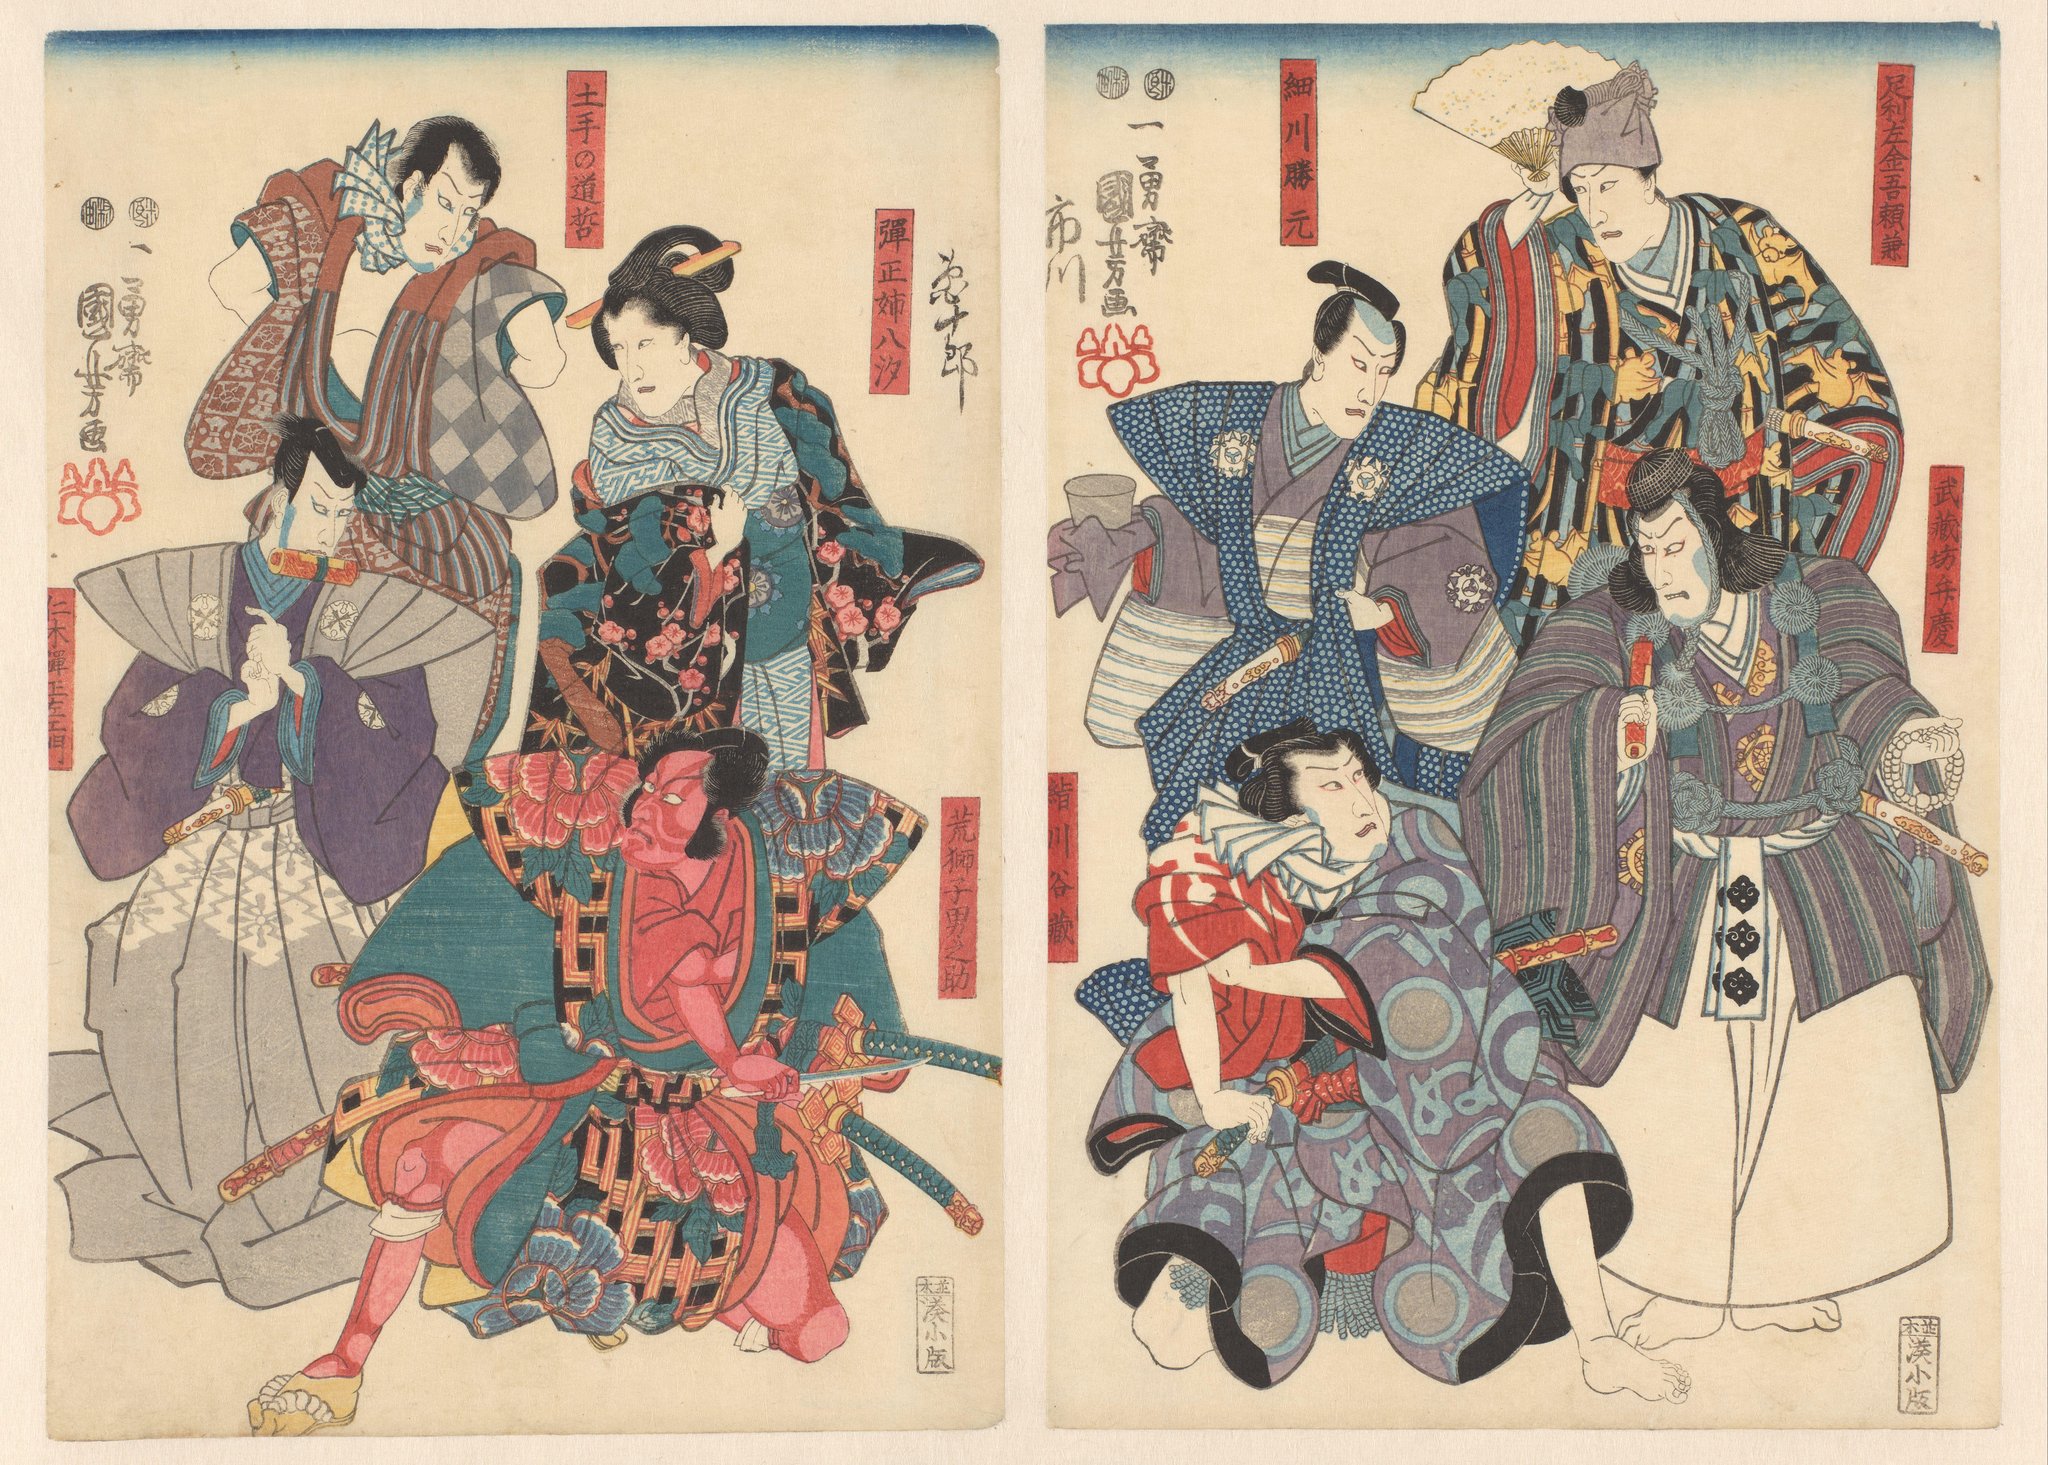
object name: print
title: Ichikawa Danjûrô VIII in eight different roles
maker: utagawa kuniyoshi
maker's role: draughtsman, print maker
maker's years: 1798-1861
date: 1849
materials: paper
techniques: woodcut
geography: japan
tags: portrait of actor, actress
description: Diptiek waarop acht portretten van kabuki acteur Ichikawa Danjurô VIII in verschillende rollen.